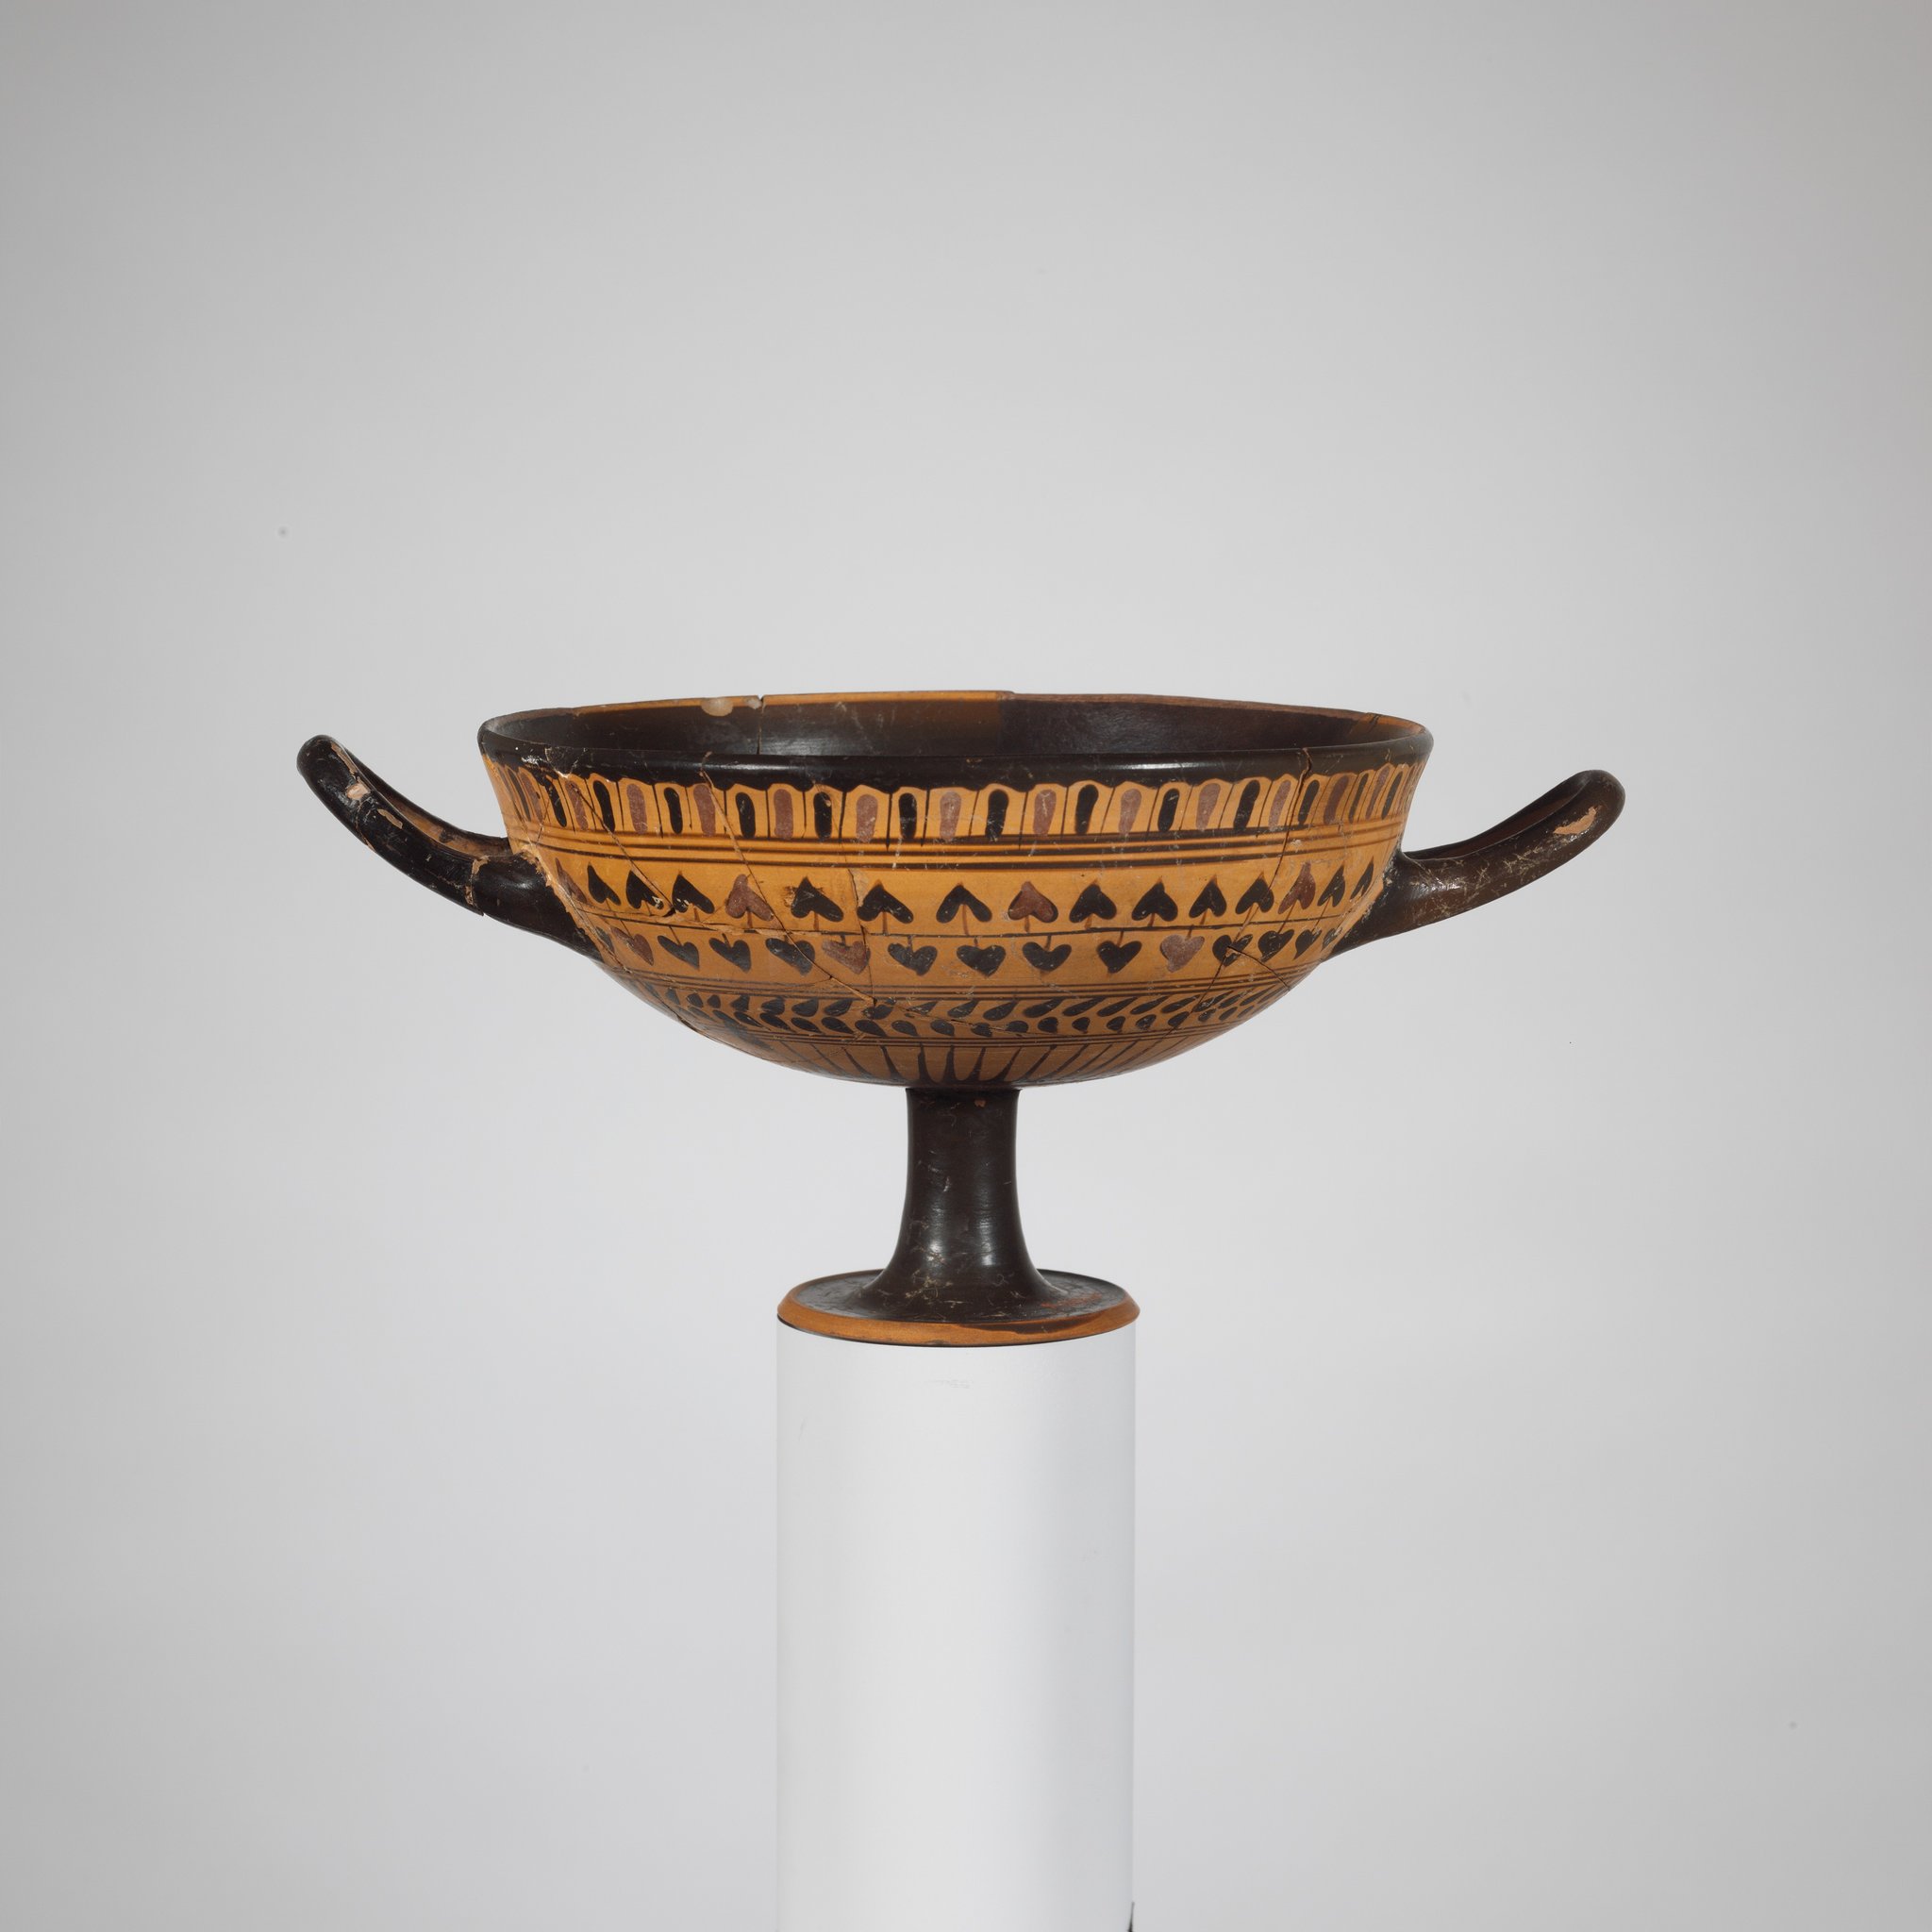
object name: kylix, cassel cup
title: Terracotta kylix: Cassel cup (drinking cup)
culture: greek, attic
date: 550-526 BCE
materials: terracotta